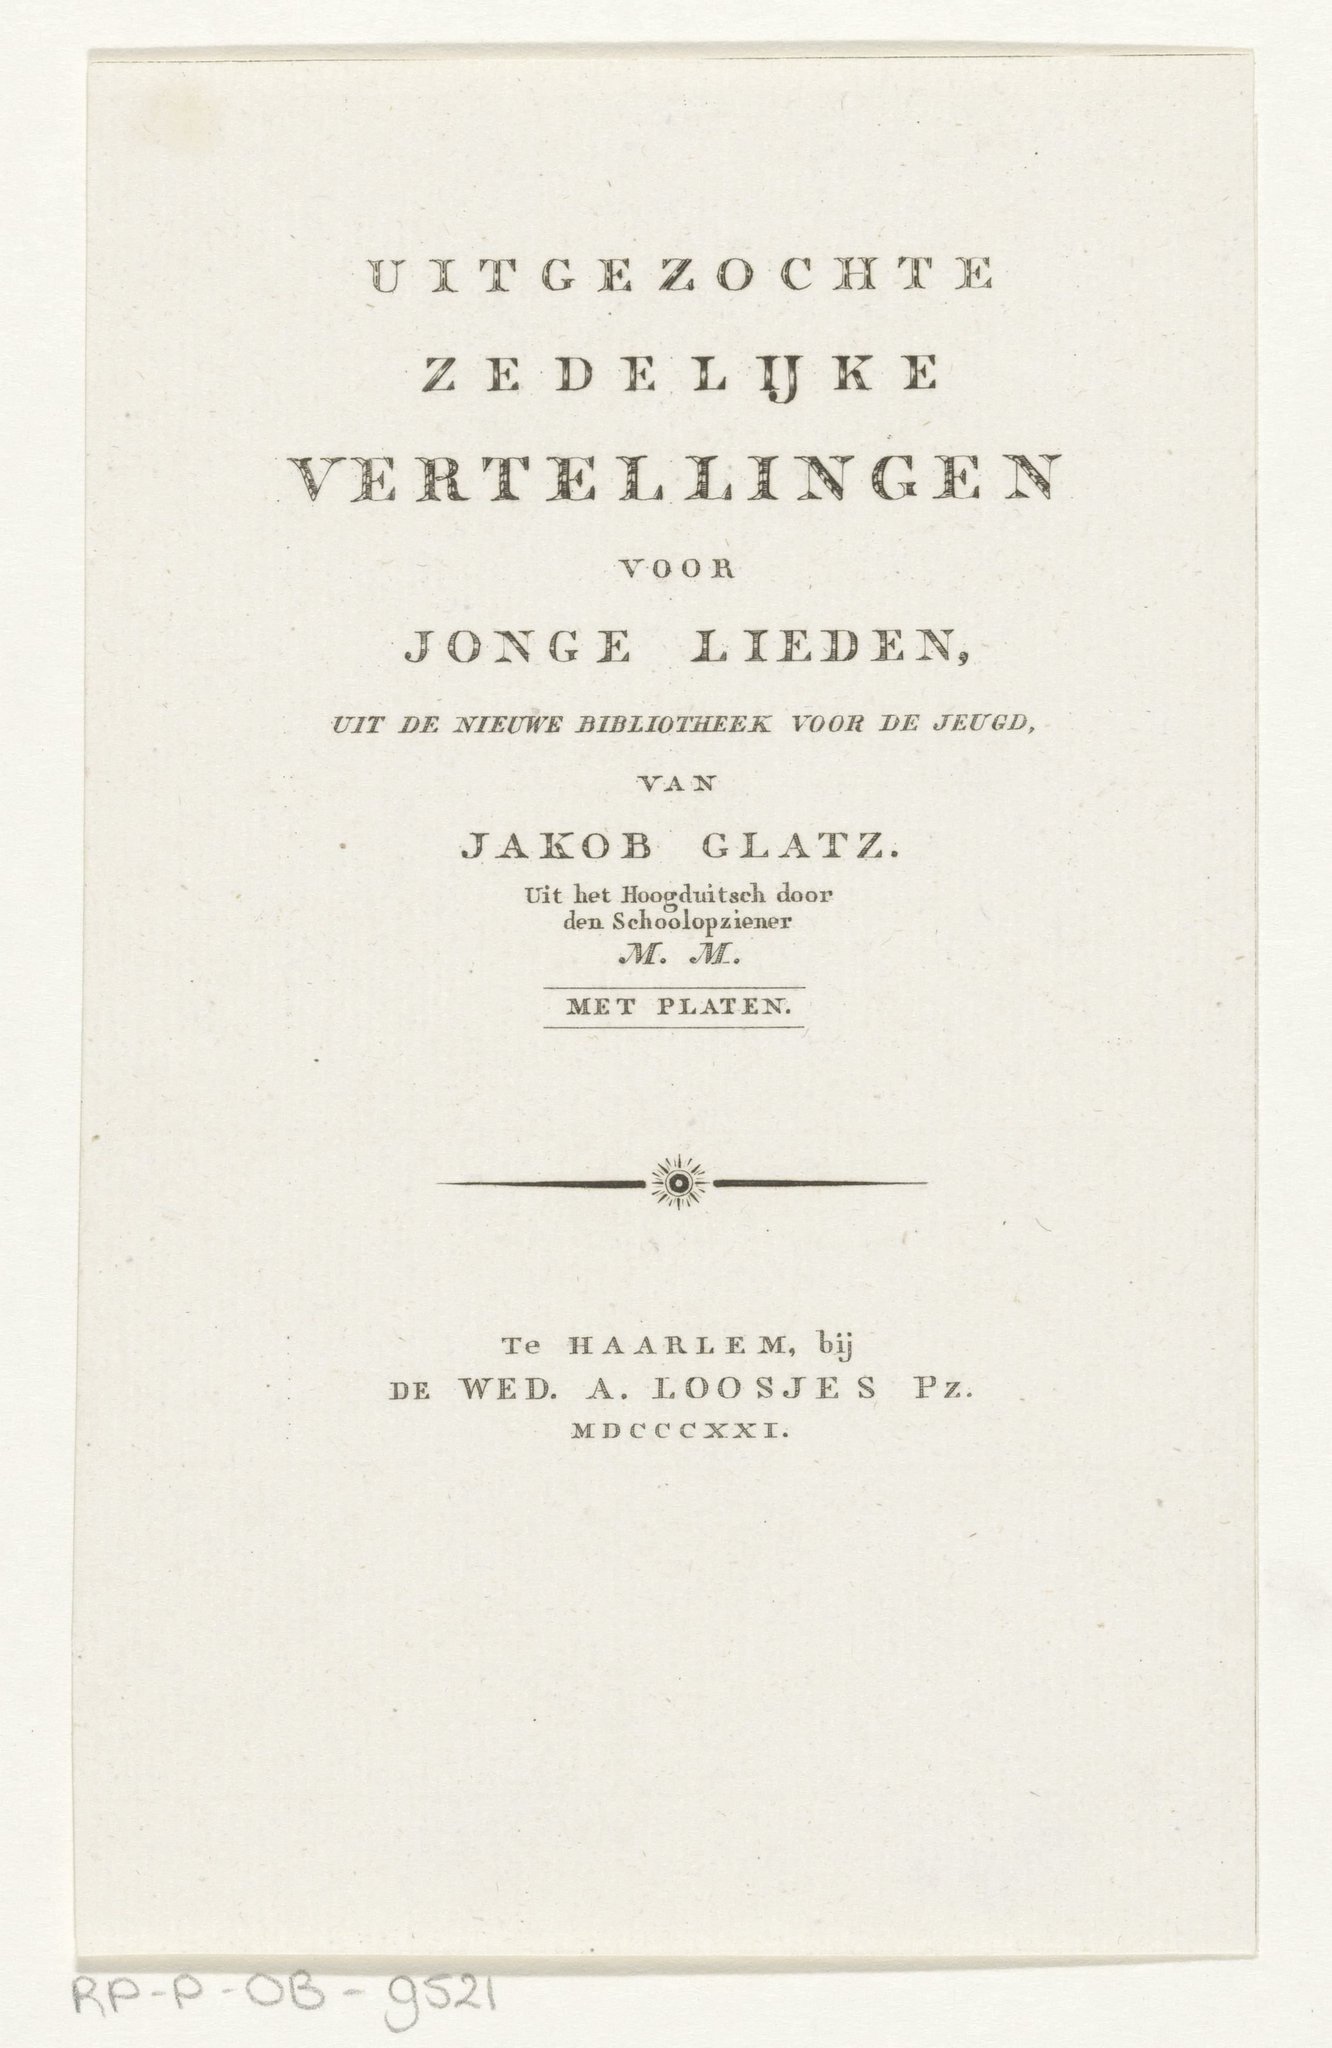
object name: print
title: Titelpagina voor: Jakob Glatz, Uitgezochte zedelijke vertellingen voor jonge lieden, 1821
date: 1821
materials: paper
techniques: engraving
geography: haarlem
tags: title-page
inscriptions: collector's mark: Lugt 2228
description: Titelpagina voor: Glatz, Jakob. Uitgezochte zedelijke vertellingen voor jonge lieden, uit de nieuwe bibliotheek voor de jeugd. Haarlem: Loosjes Pz., weduwe Adriaan, 1821.